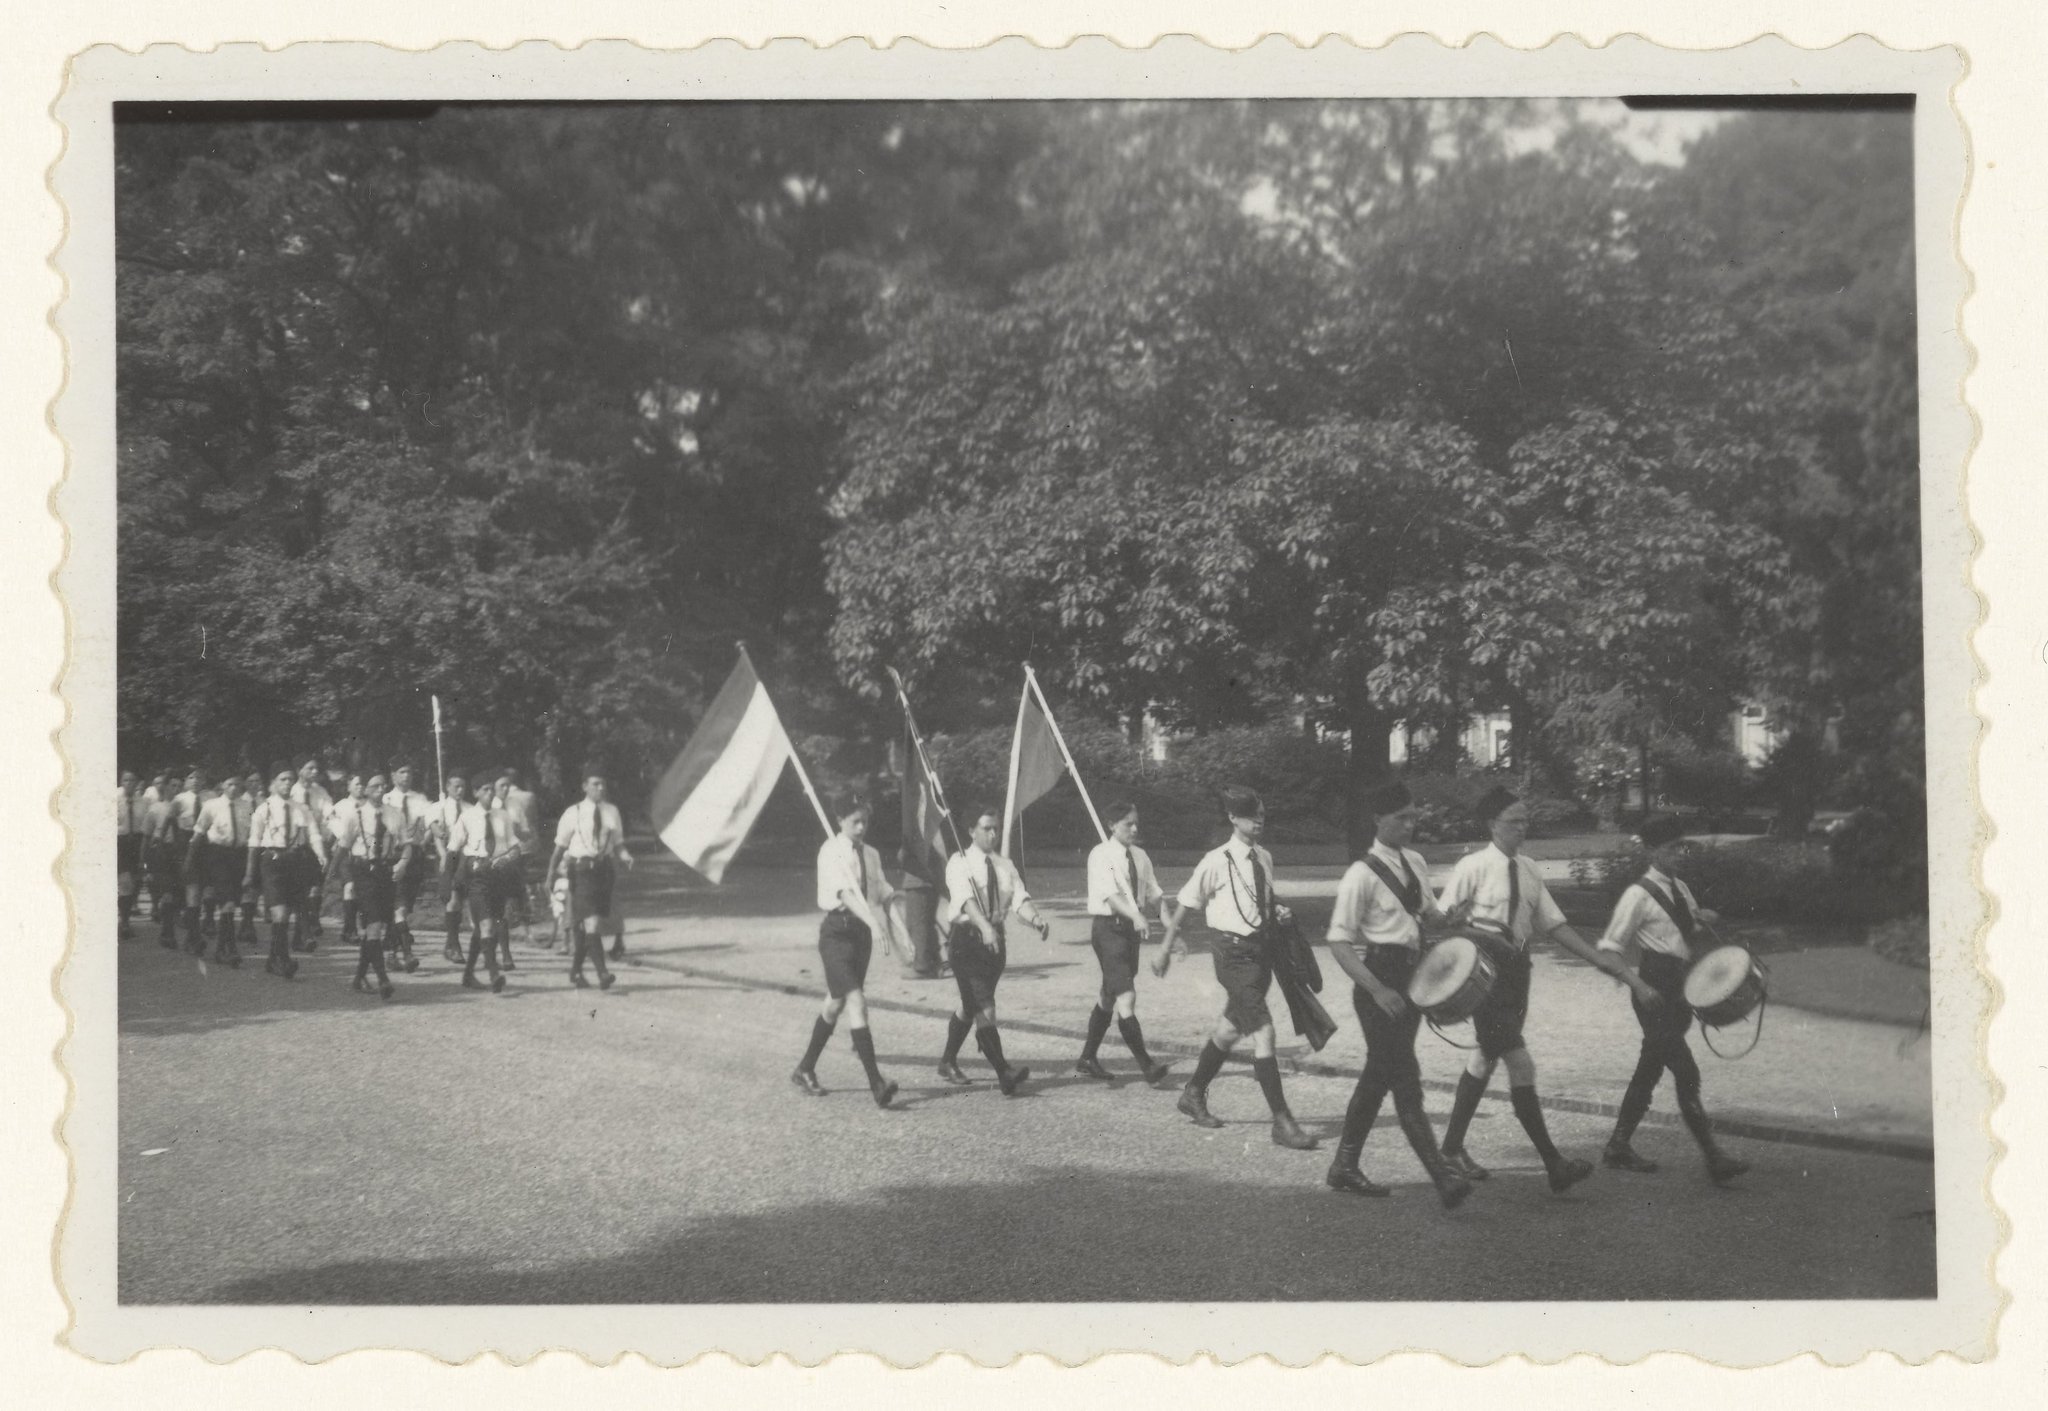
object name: photograph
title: Optocht Jeugdstorm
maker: Anonymous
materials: photographic support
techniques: gelatin silver print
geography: utrecht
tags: military instruction, utrecht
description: Een optocht van de Jeugdstorm. Voorop twee mannen met trommels, verderop in de stoet de Nederlandse vlag, Jeugdstorm vlag en een derde vlag. De stoet loopt het Wilhelminapark? uit. Allen zijn in uniform.